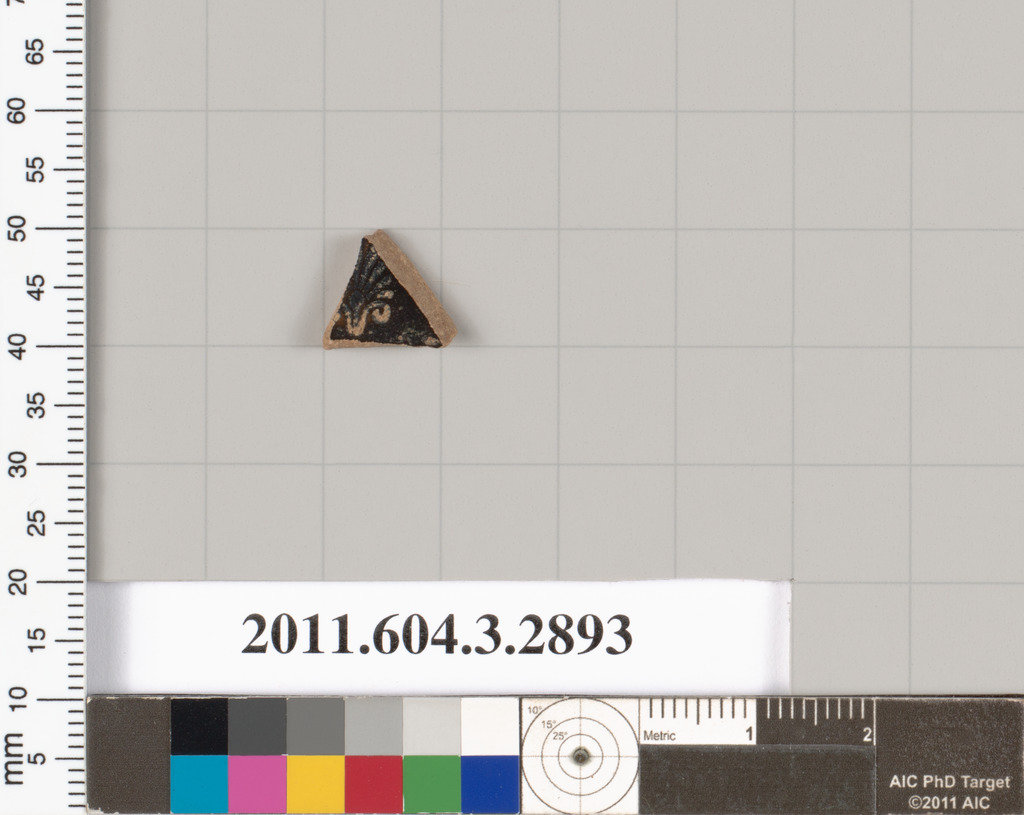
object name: undetermined open shape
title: Terracotta fragment of an open shape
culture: greek, attic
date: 450-426 BCE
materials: terracotta